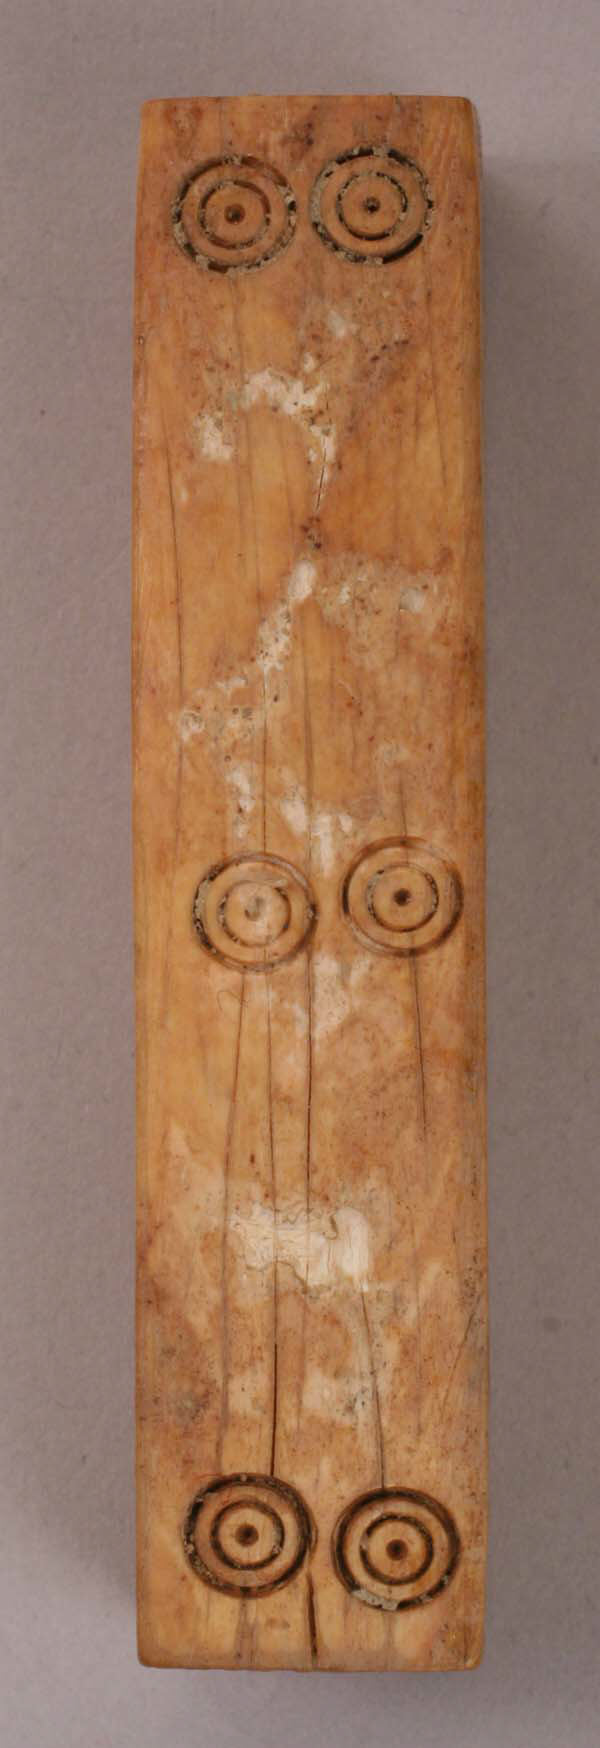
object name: die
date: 901-1100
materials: ivory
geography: egypt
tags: dice